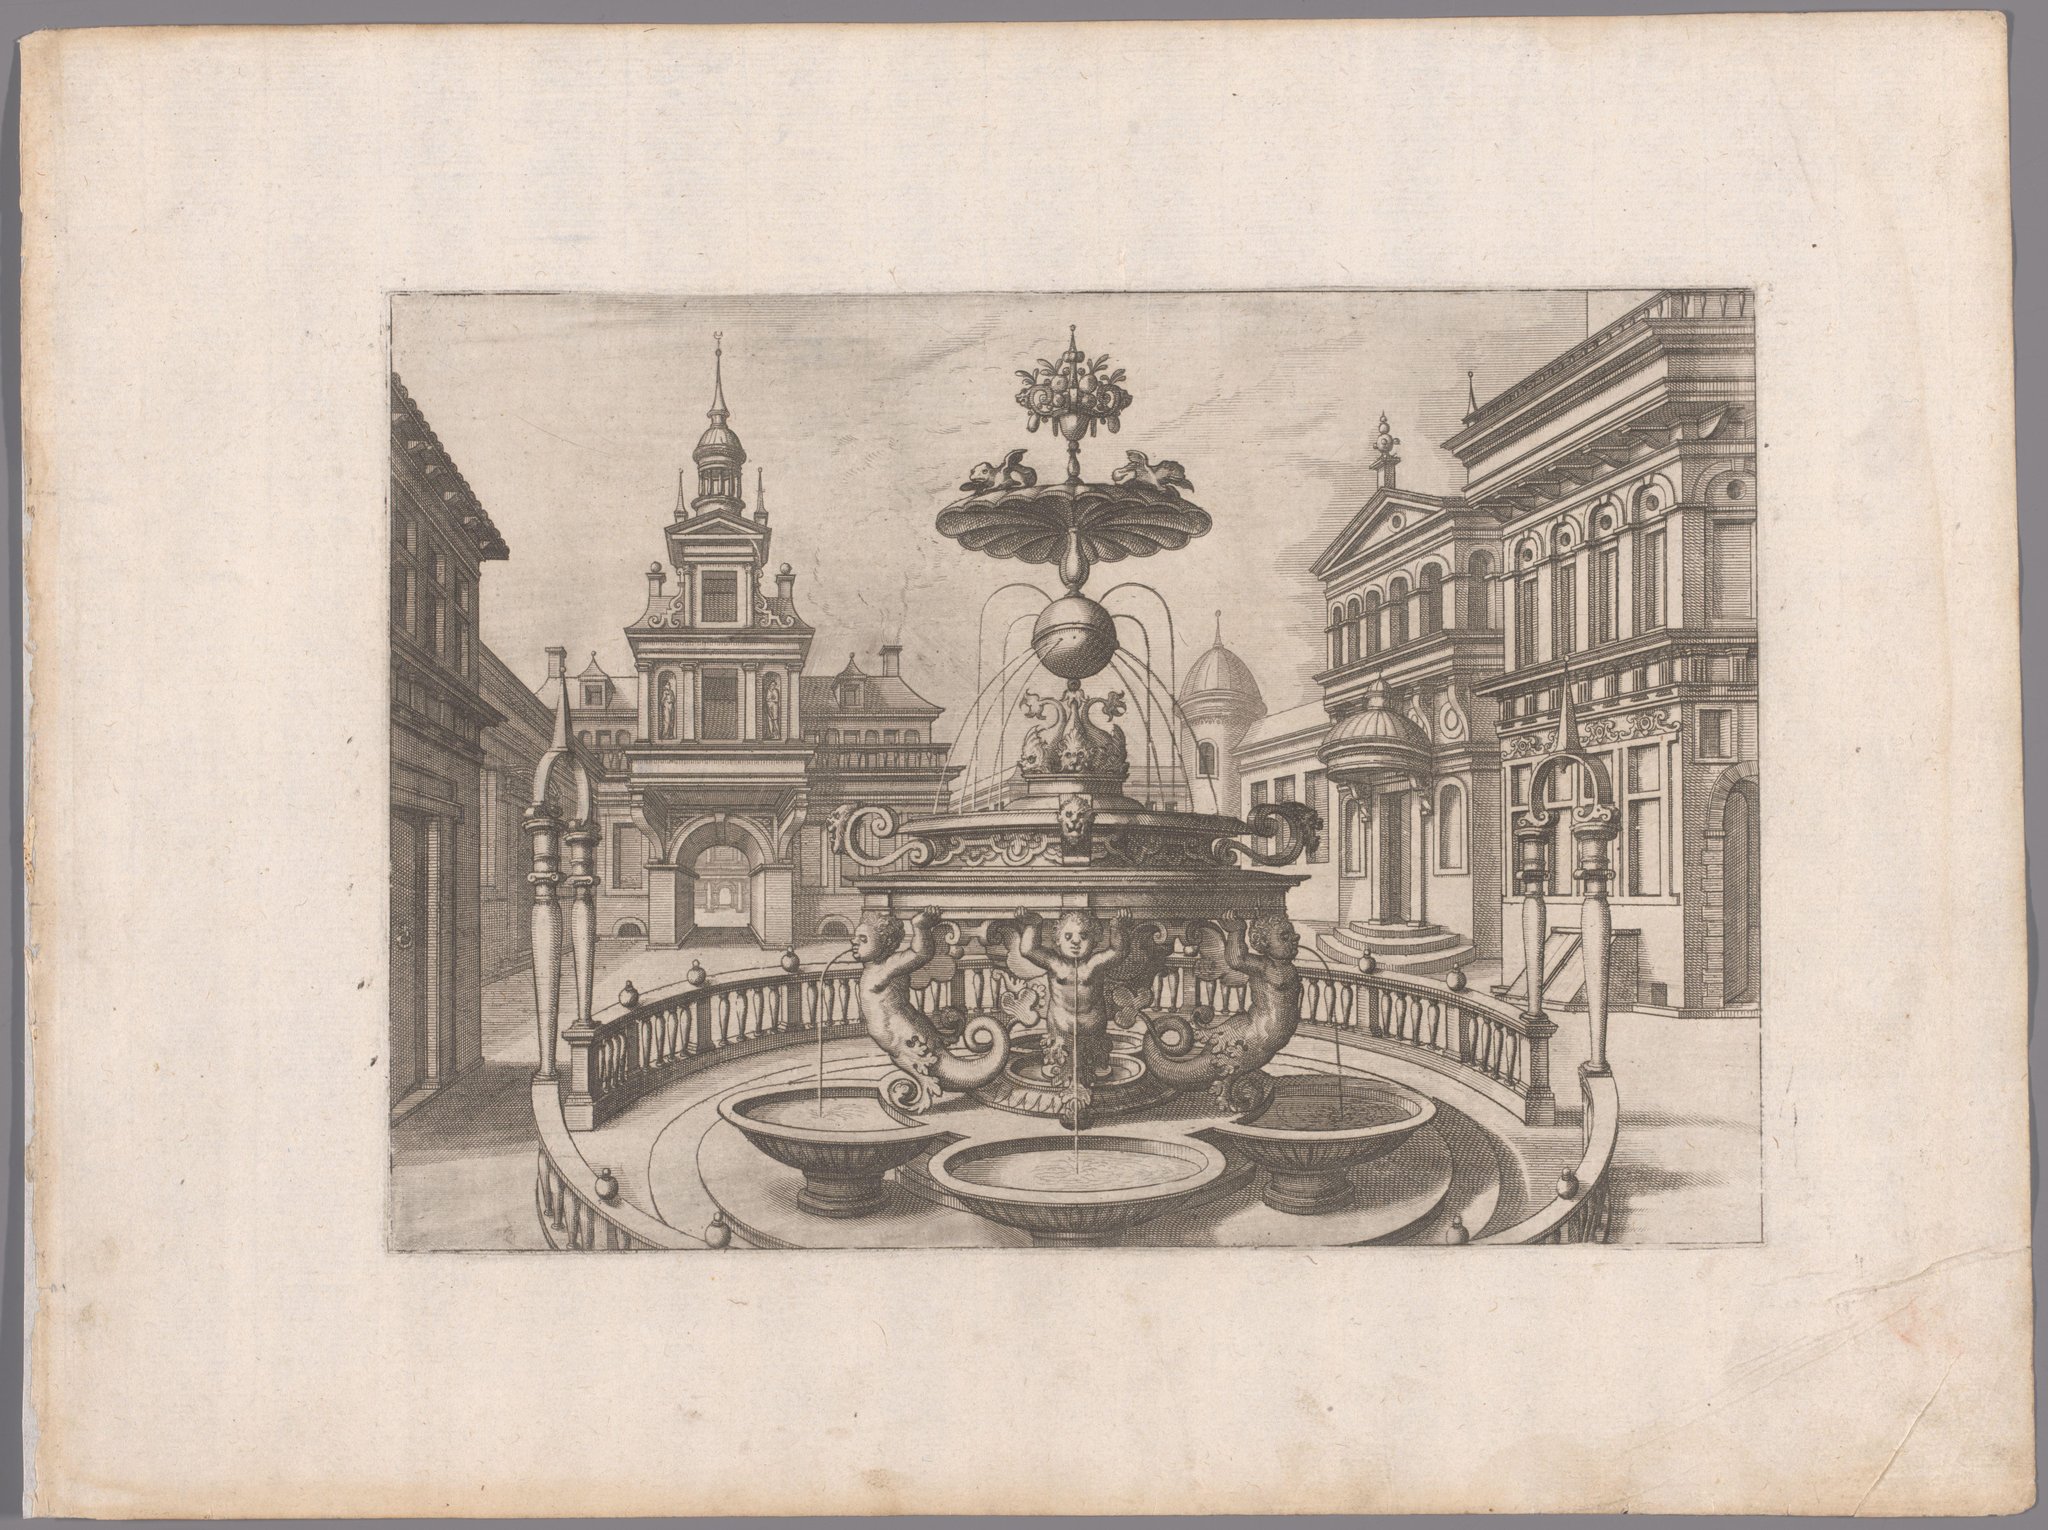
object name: ornament print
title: Artis Perspectivae (...)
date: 1568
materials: paper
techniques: etching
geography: antwerp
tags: ornamental fountain, civic architecture; edifices; dwellings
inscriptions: collector's mark: Lugt 2228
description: Stadsplein met een ronde fontein omgeven door een balustrade met twee toegangen. Het basin wordt gedragen door putti met een vissenstaart.